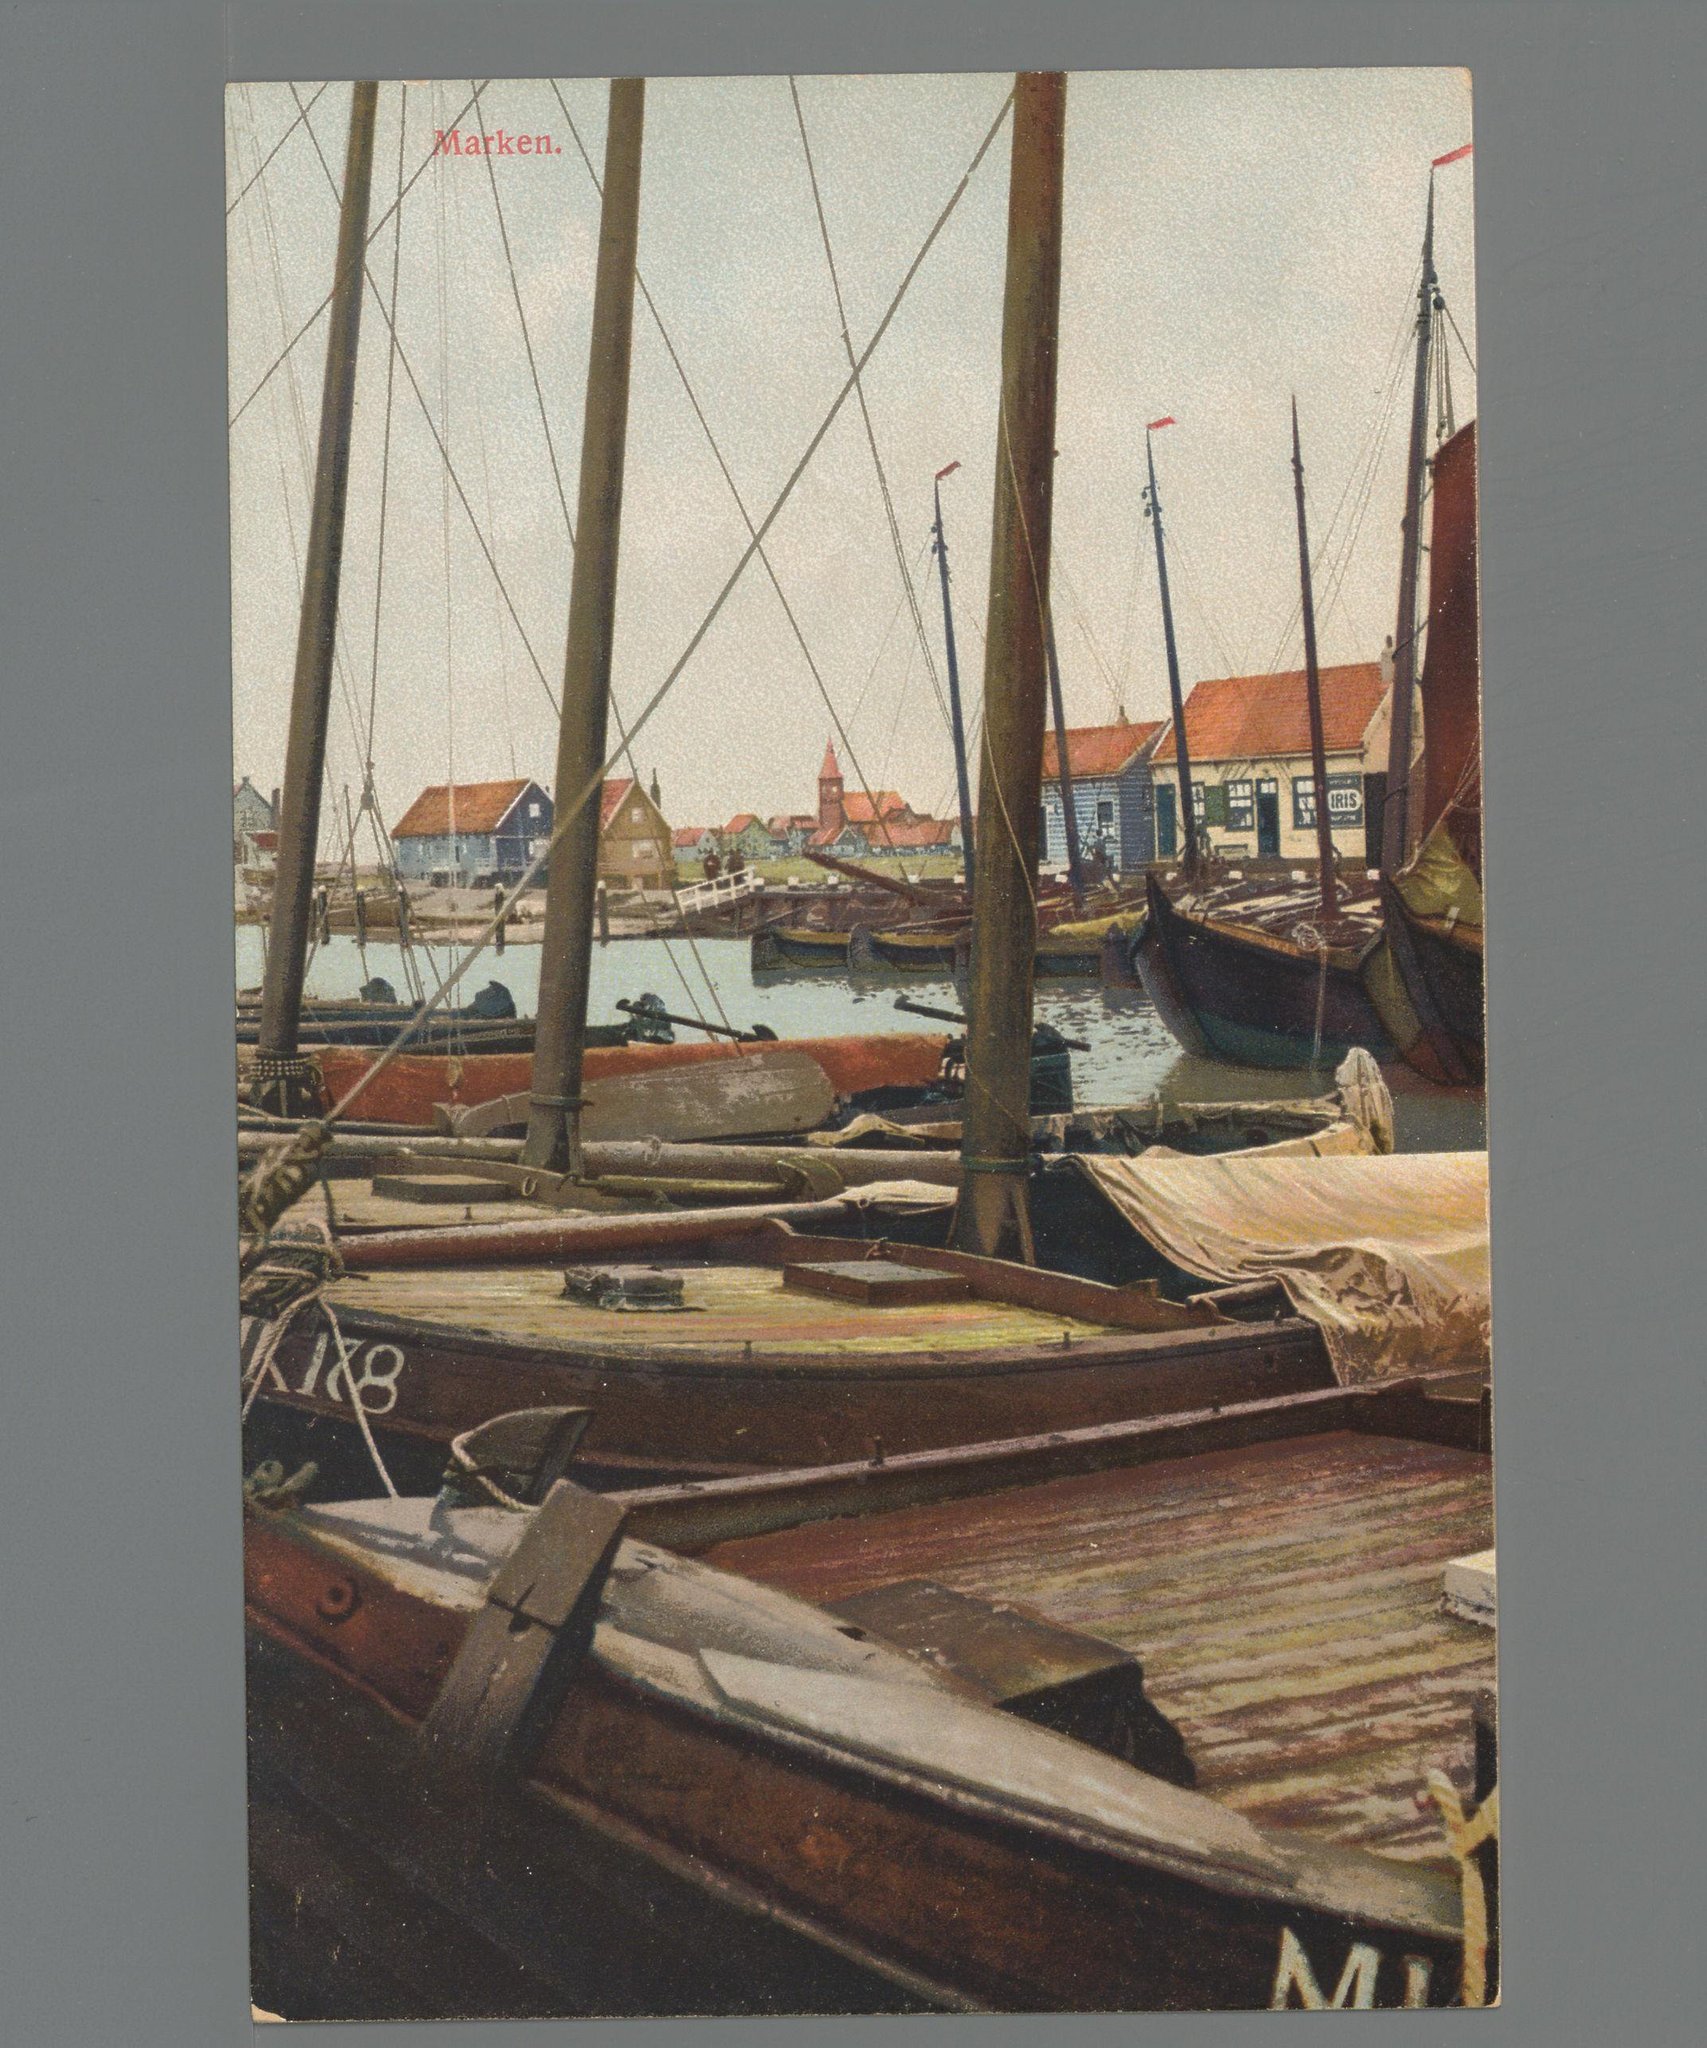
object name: ansichtkaart, prentbriefkaart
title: Marken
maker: Anonymous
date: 1906-1945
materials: cardboard, photographic process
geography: marken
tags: sailing-ship, sailing-boat, village